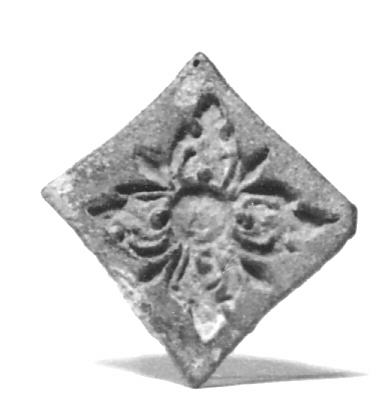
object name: mold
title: Mold (Square-Shaped with Flower)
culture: indonesian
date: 901-1100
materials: bronze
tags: flowers